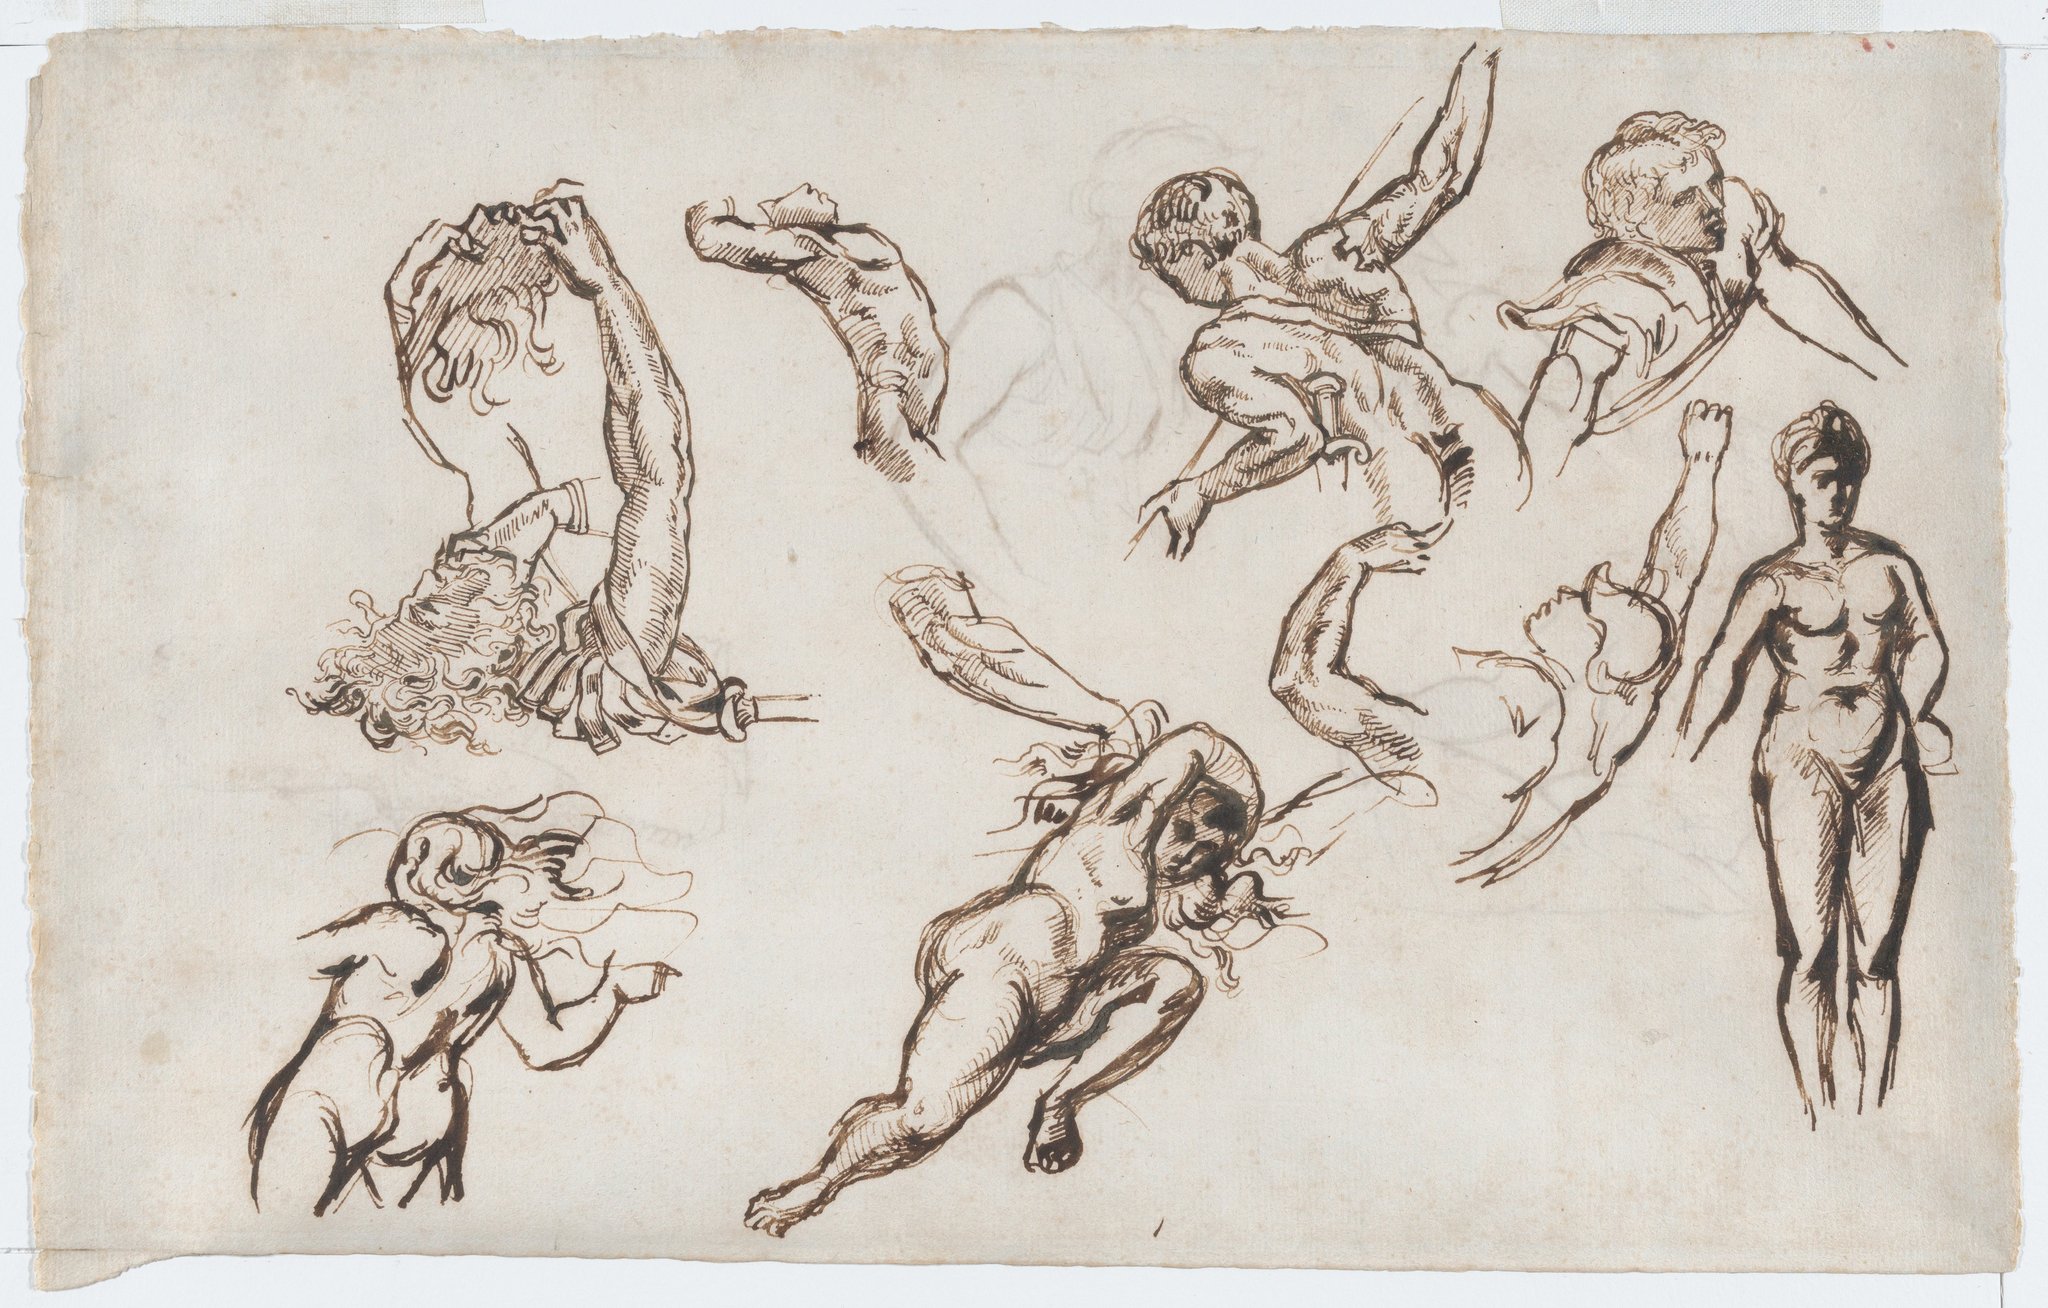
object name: drawing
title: Eight Studies of Nude Figures (recto); Figure Studies from the Antique and a Caricature (verso)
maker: eugène delacroix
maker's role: artist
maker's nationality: french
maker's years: 1798-1863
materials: ink, iron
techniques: pen